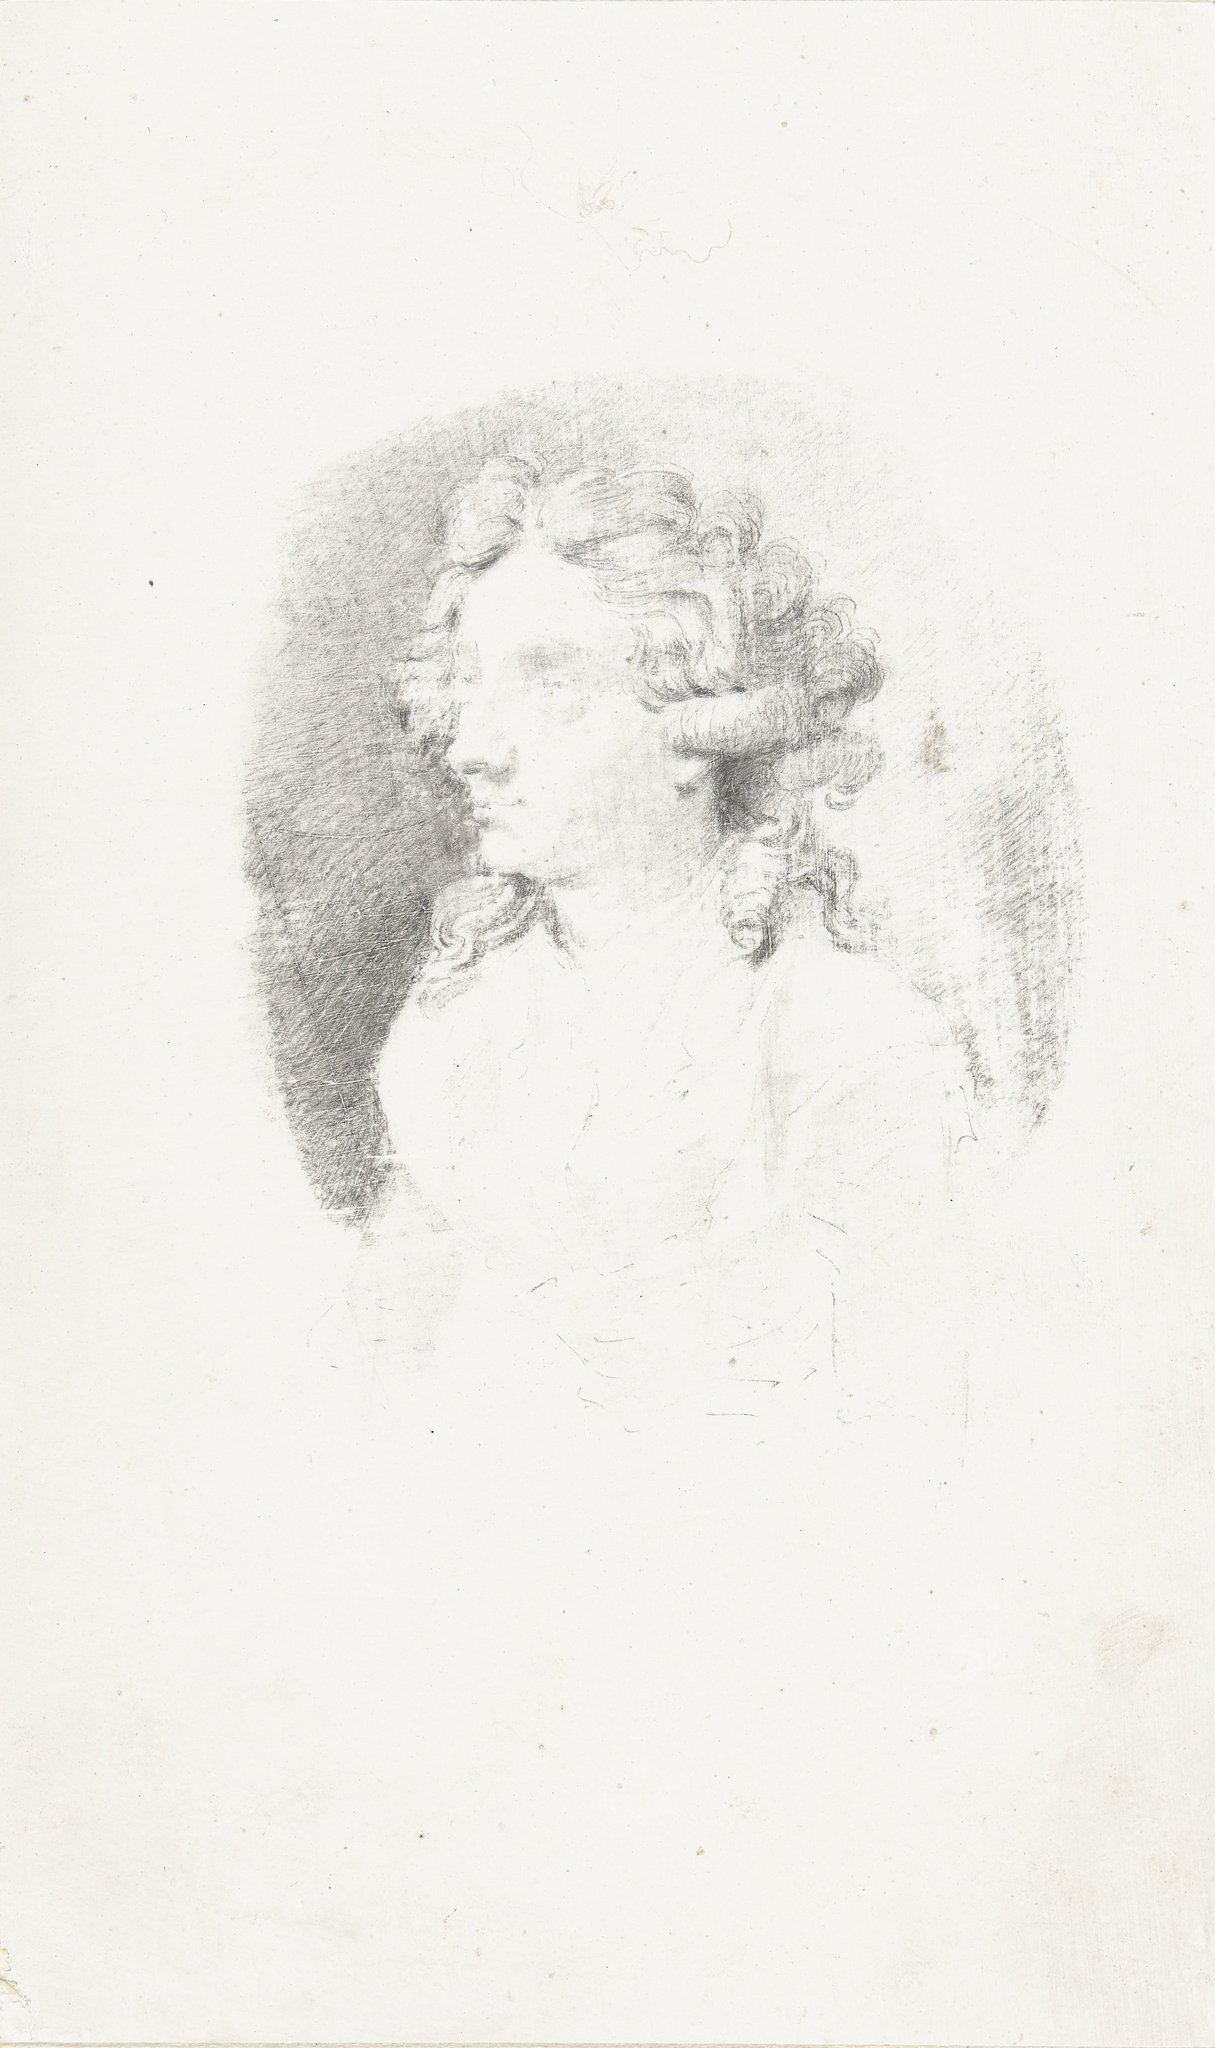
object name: drawing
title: Borstbeeld van een jonge vrouw, naar links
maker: taco scheltema (i)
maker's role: draughtsman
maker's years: 1760-1837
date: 1770-1837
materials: pencil, paper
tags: anonymous historical person portrayed alone